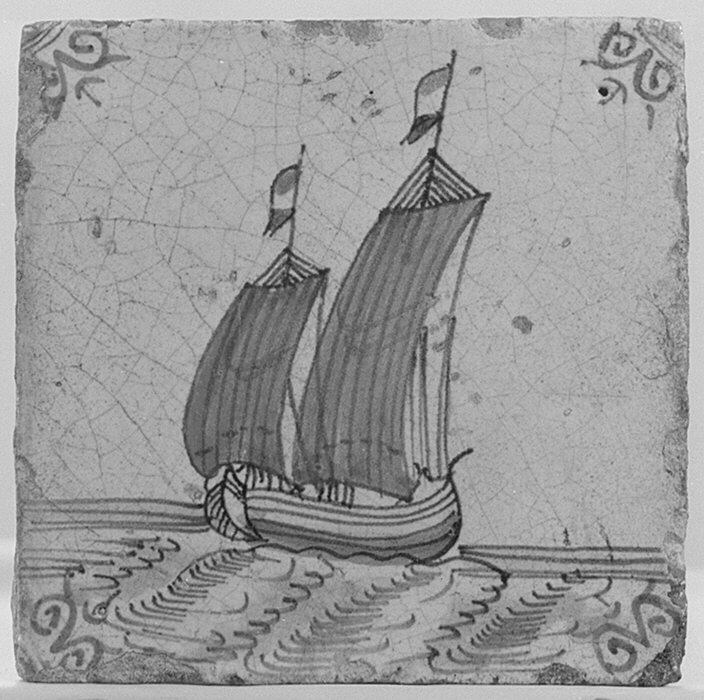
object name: tile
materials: earthenware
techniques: glazing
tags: ships